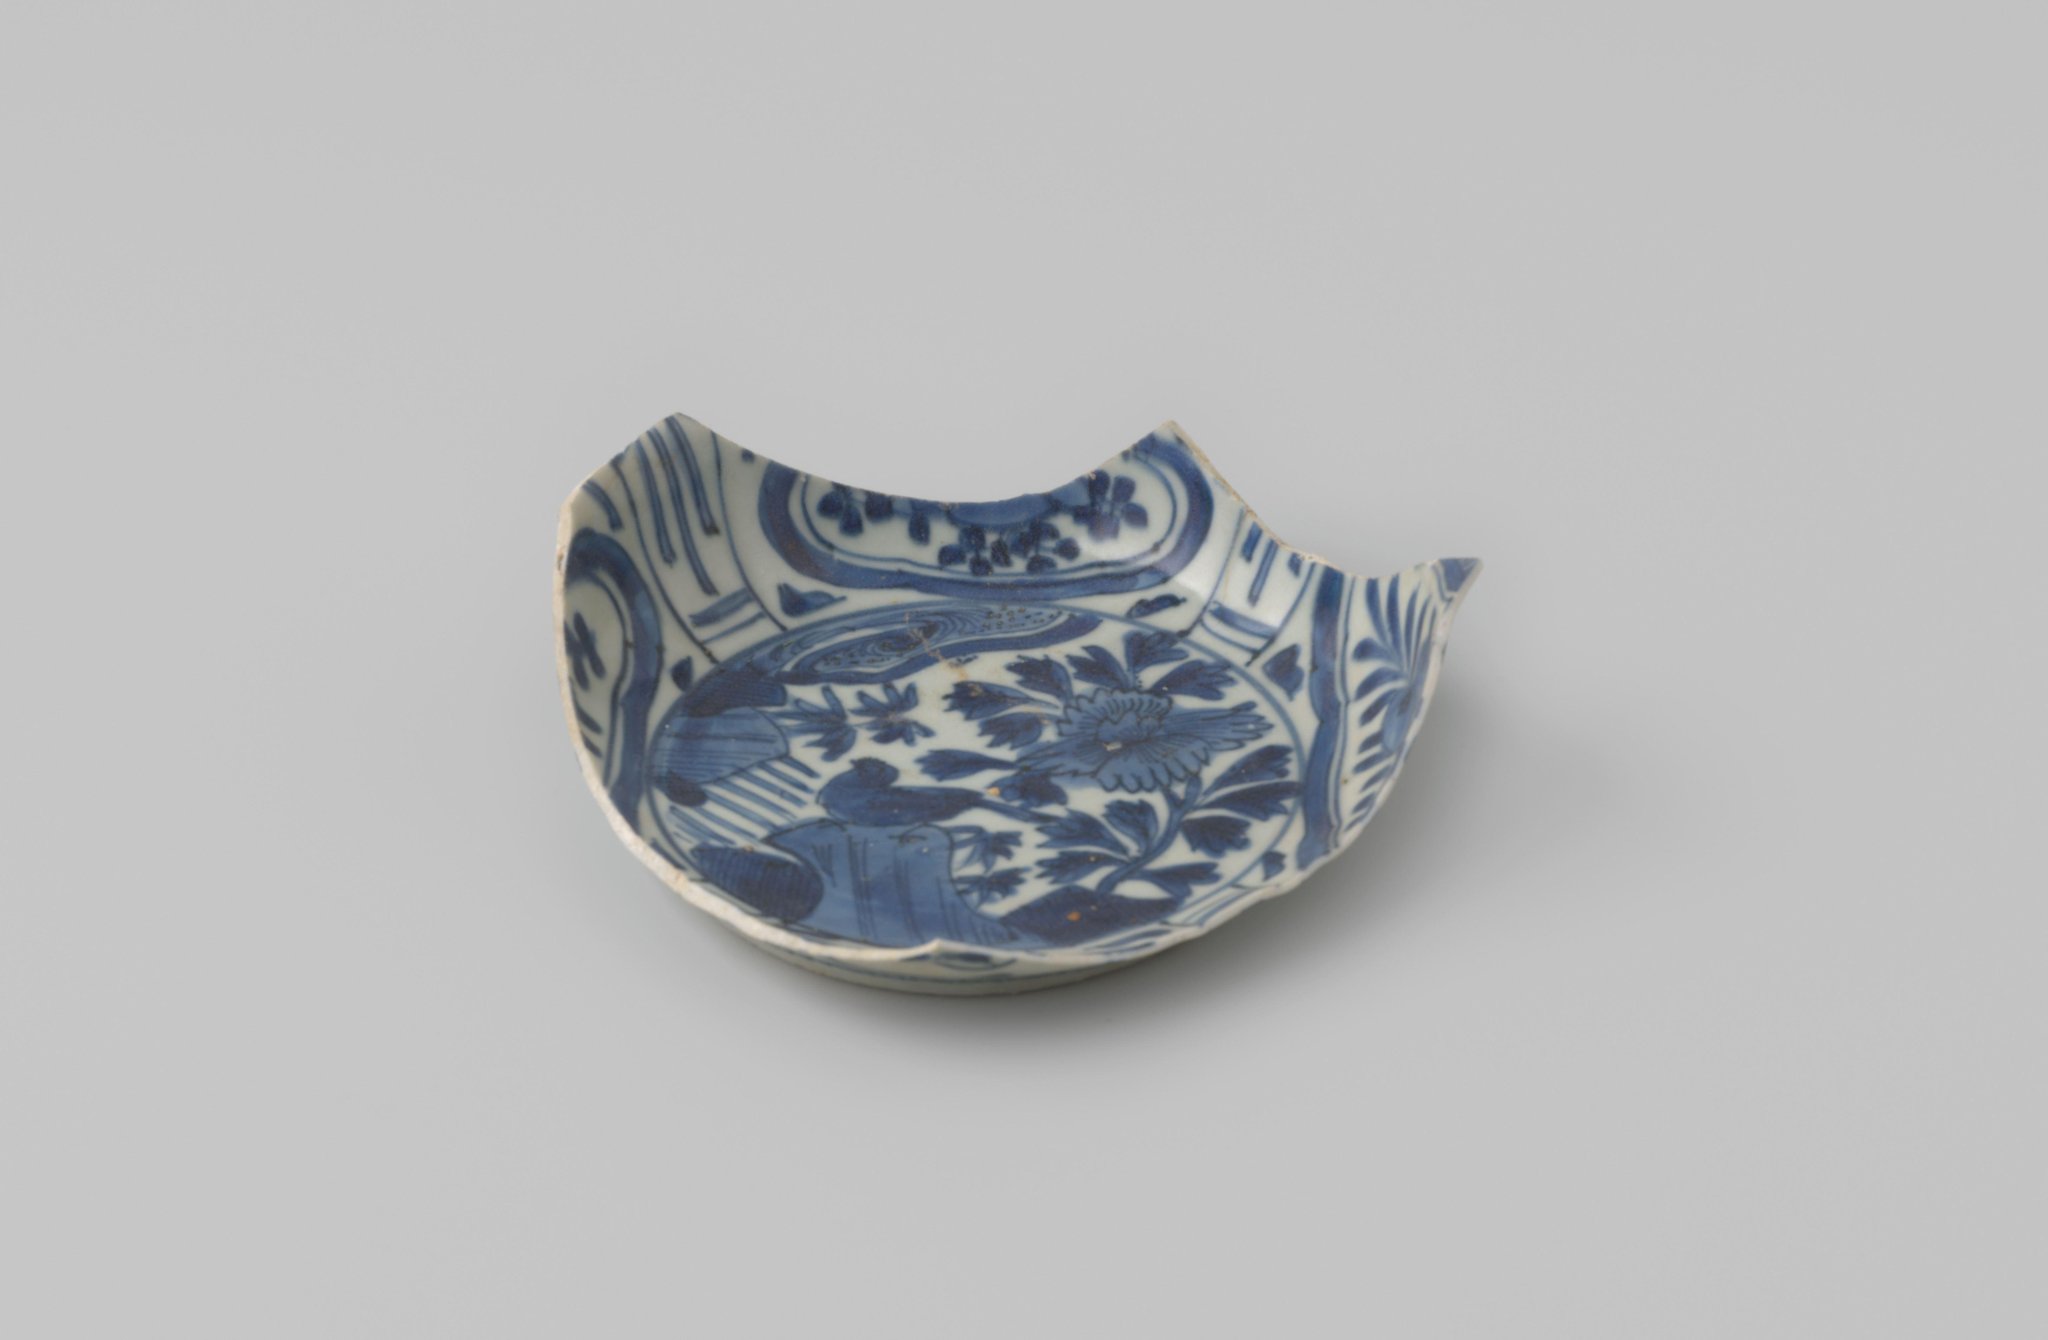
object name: plate dish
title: Fragment diep bord uit V.O.C.-schip de 'Witte Leeuw'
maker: Anonymous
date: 1613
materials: bone china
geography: jingdezhen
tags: verenigde oostindische compagnie, sint-helena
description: Fragment diep bord uit V.O.C.-schip de 'Witte Leeuw'. 55% aanwezig.